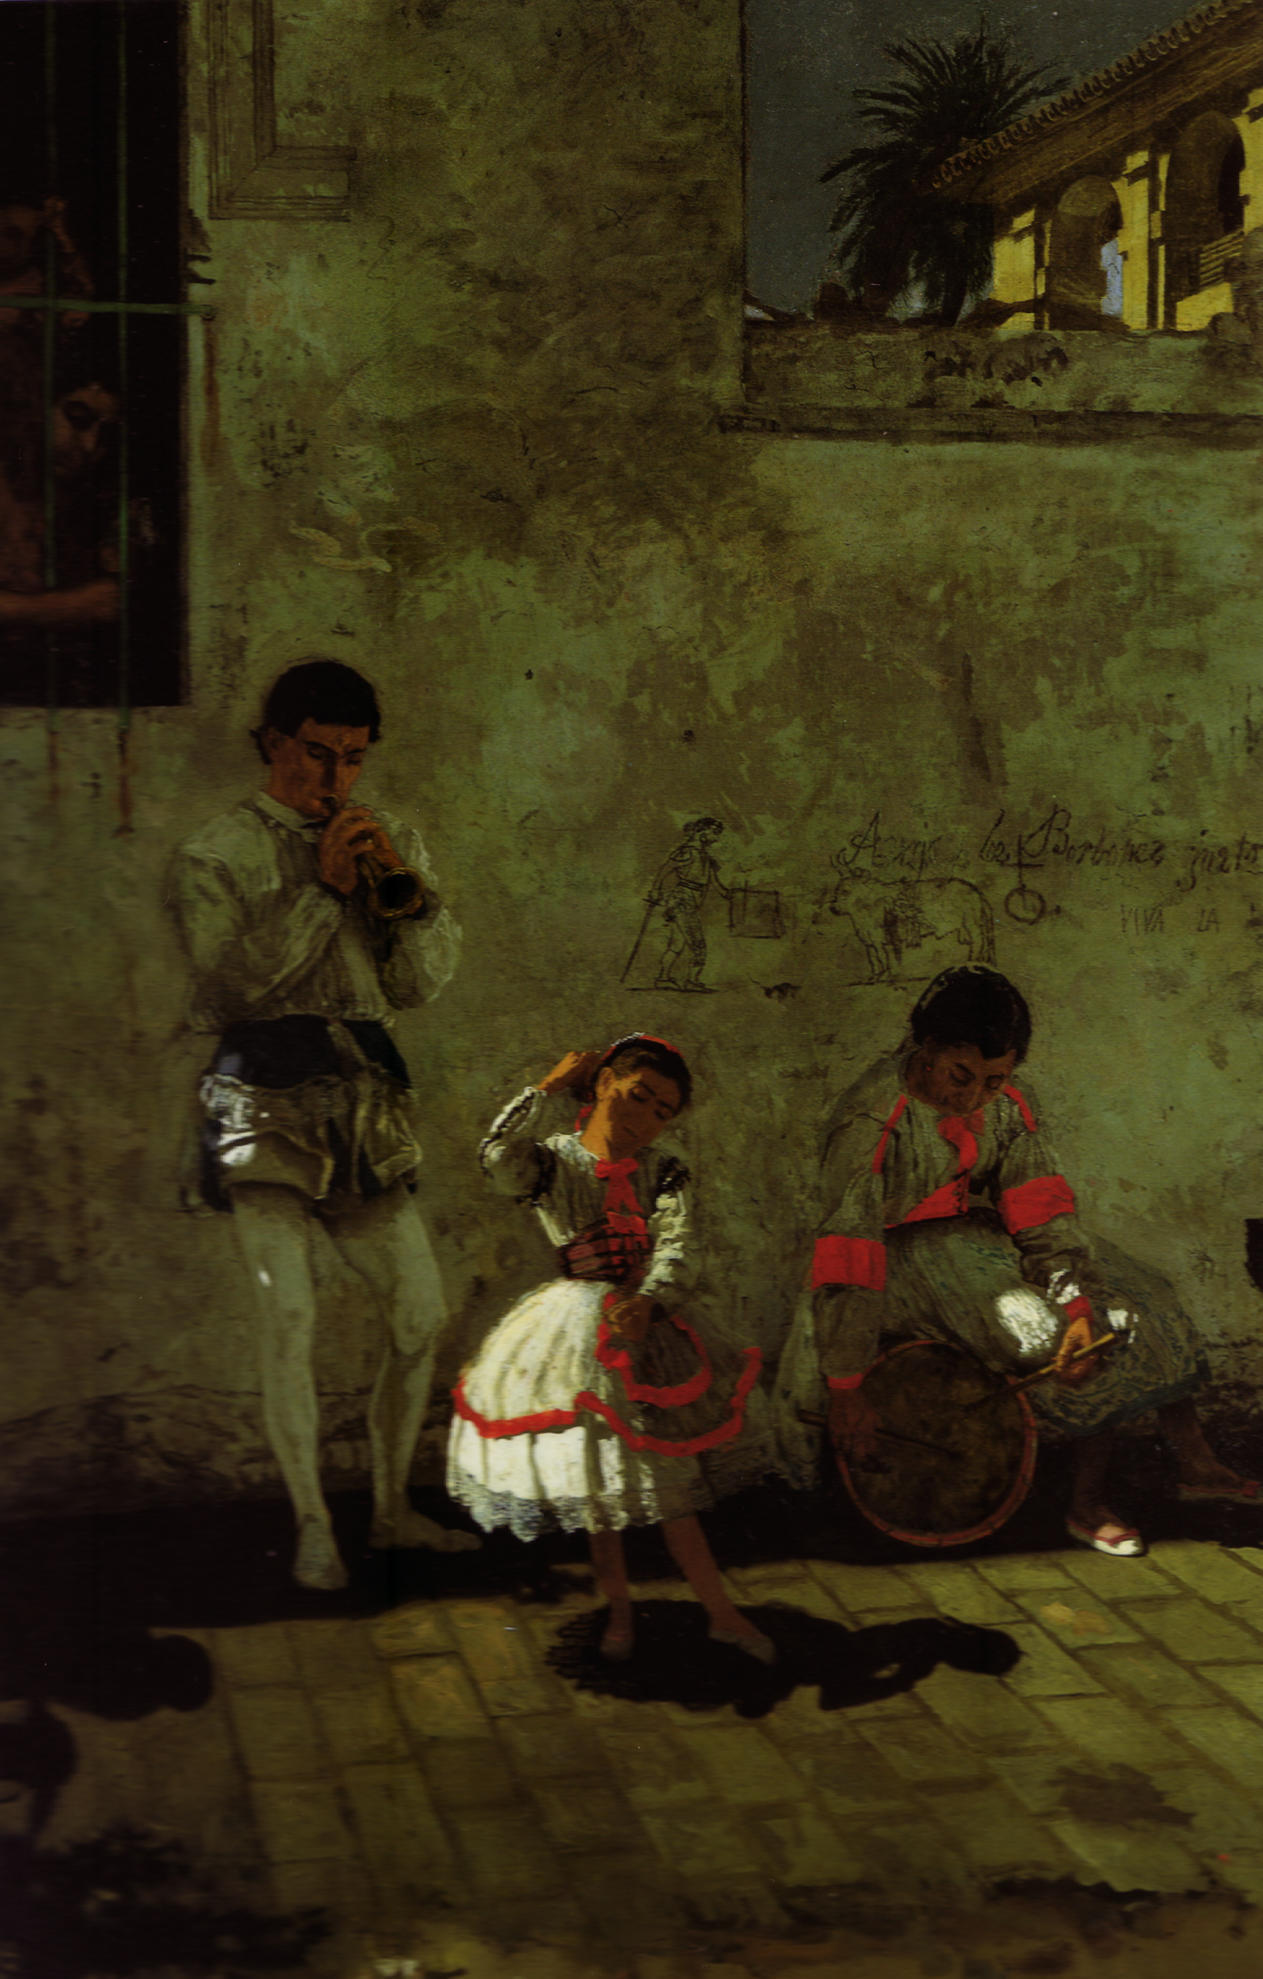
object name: painting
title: A Street Scene in Seville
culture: american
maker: thomas eakins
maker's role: artist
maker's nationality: american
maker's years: 1844-1916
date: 1870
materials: canvas, oil